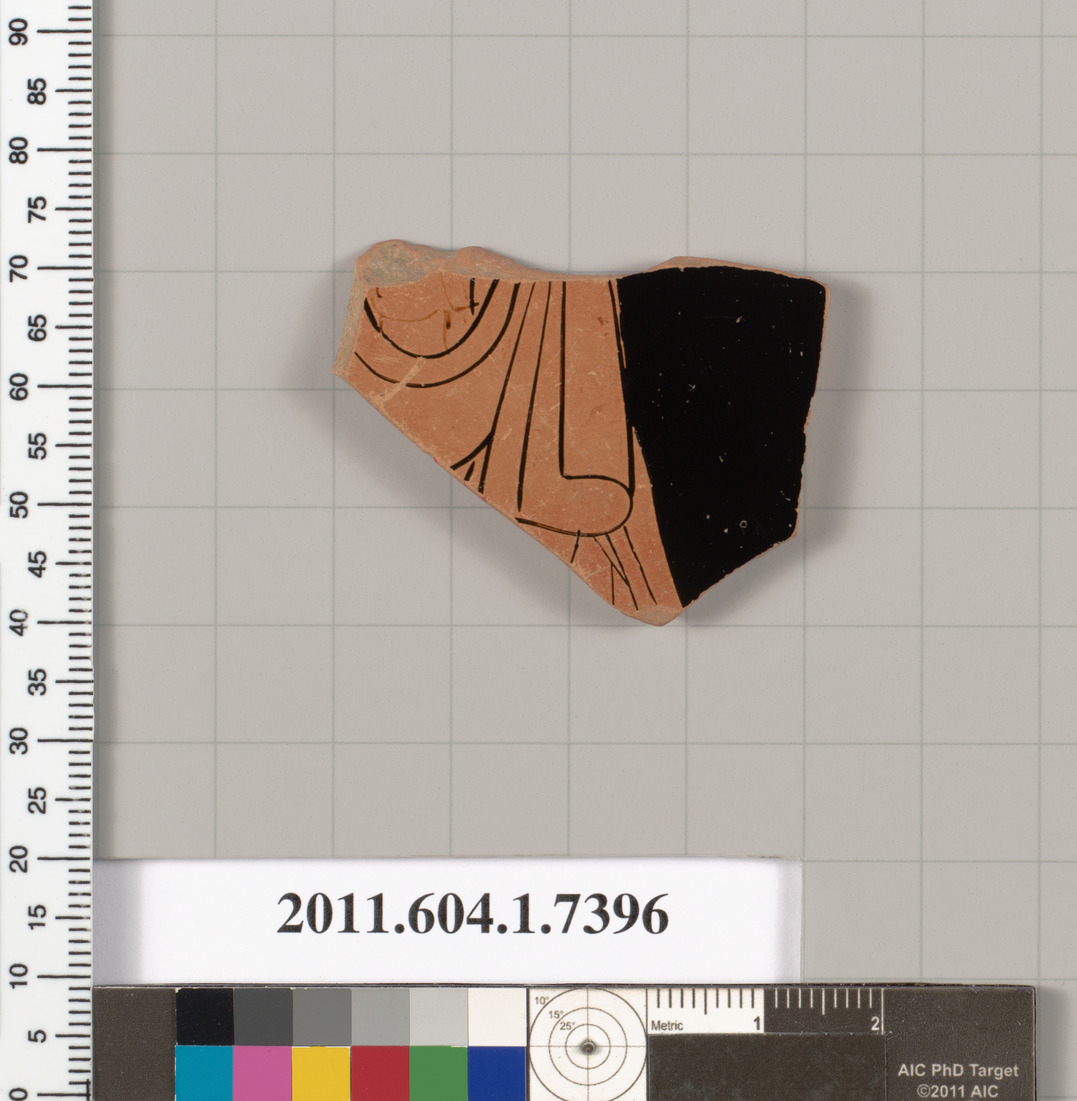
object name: kylix fragment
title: Terracotta fragment of a kylix (drinking cup)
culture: greek, attic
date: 500-480 BCE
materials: terracotta